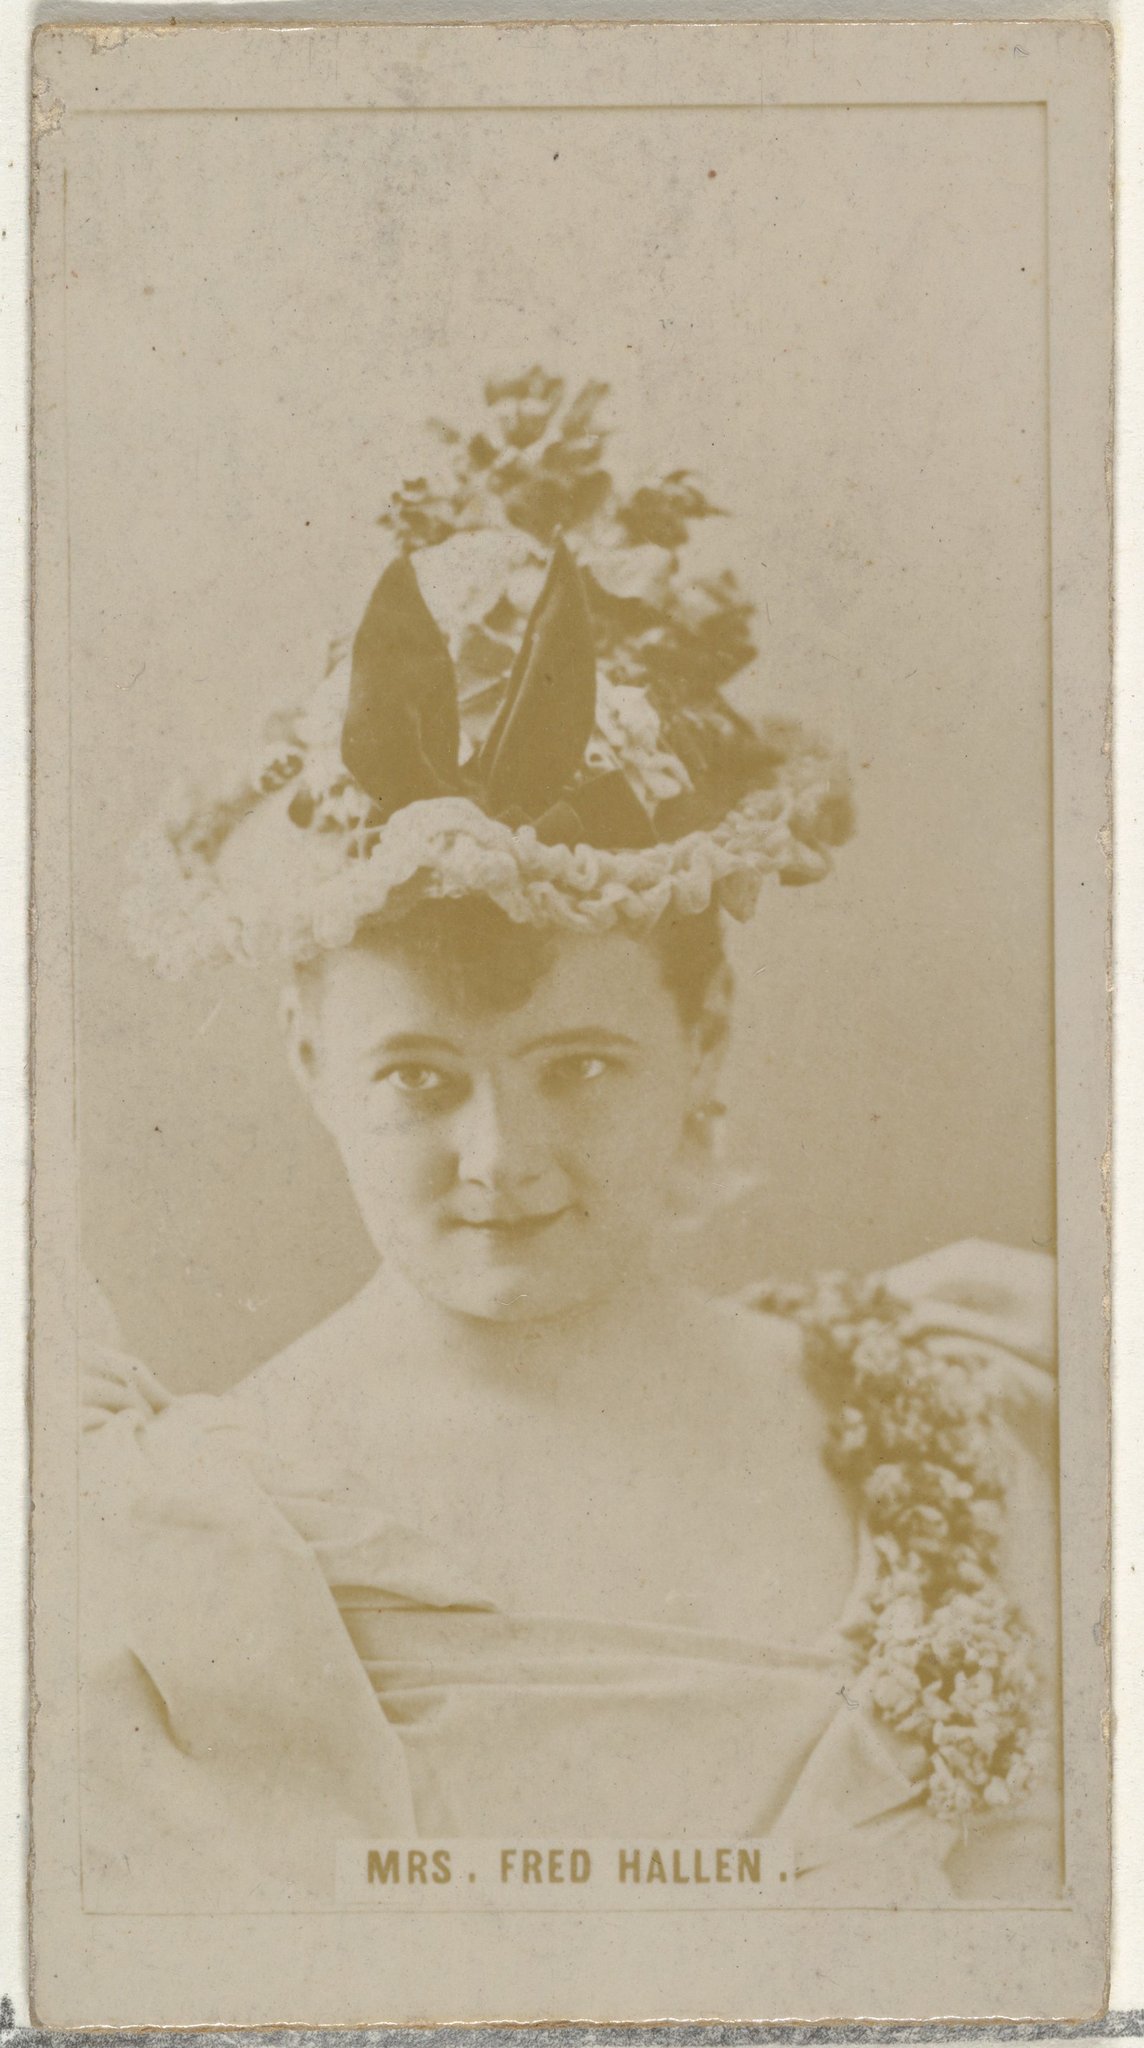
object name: photograph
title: Mrs. Fred Hallen, from the Actors and Actresses series (N145-8) issued by Duke Sons & Co. to promote Duke Cigarettes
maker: w. duke, sons & co.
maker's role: publisher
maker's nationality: american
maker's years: 1870-1920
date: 1891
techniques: albumen silver print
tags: portraits,women,actresses